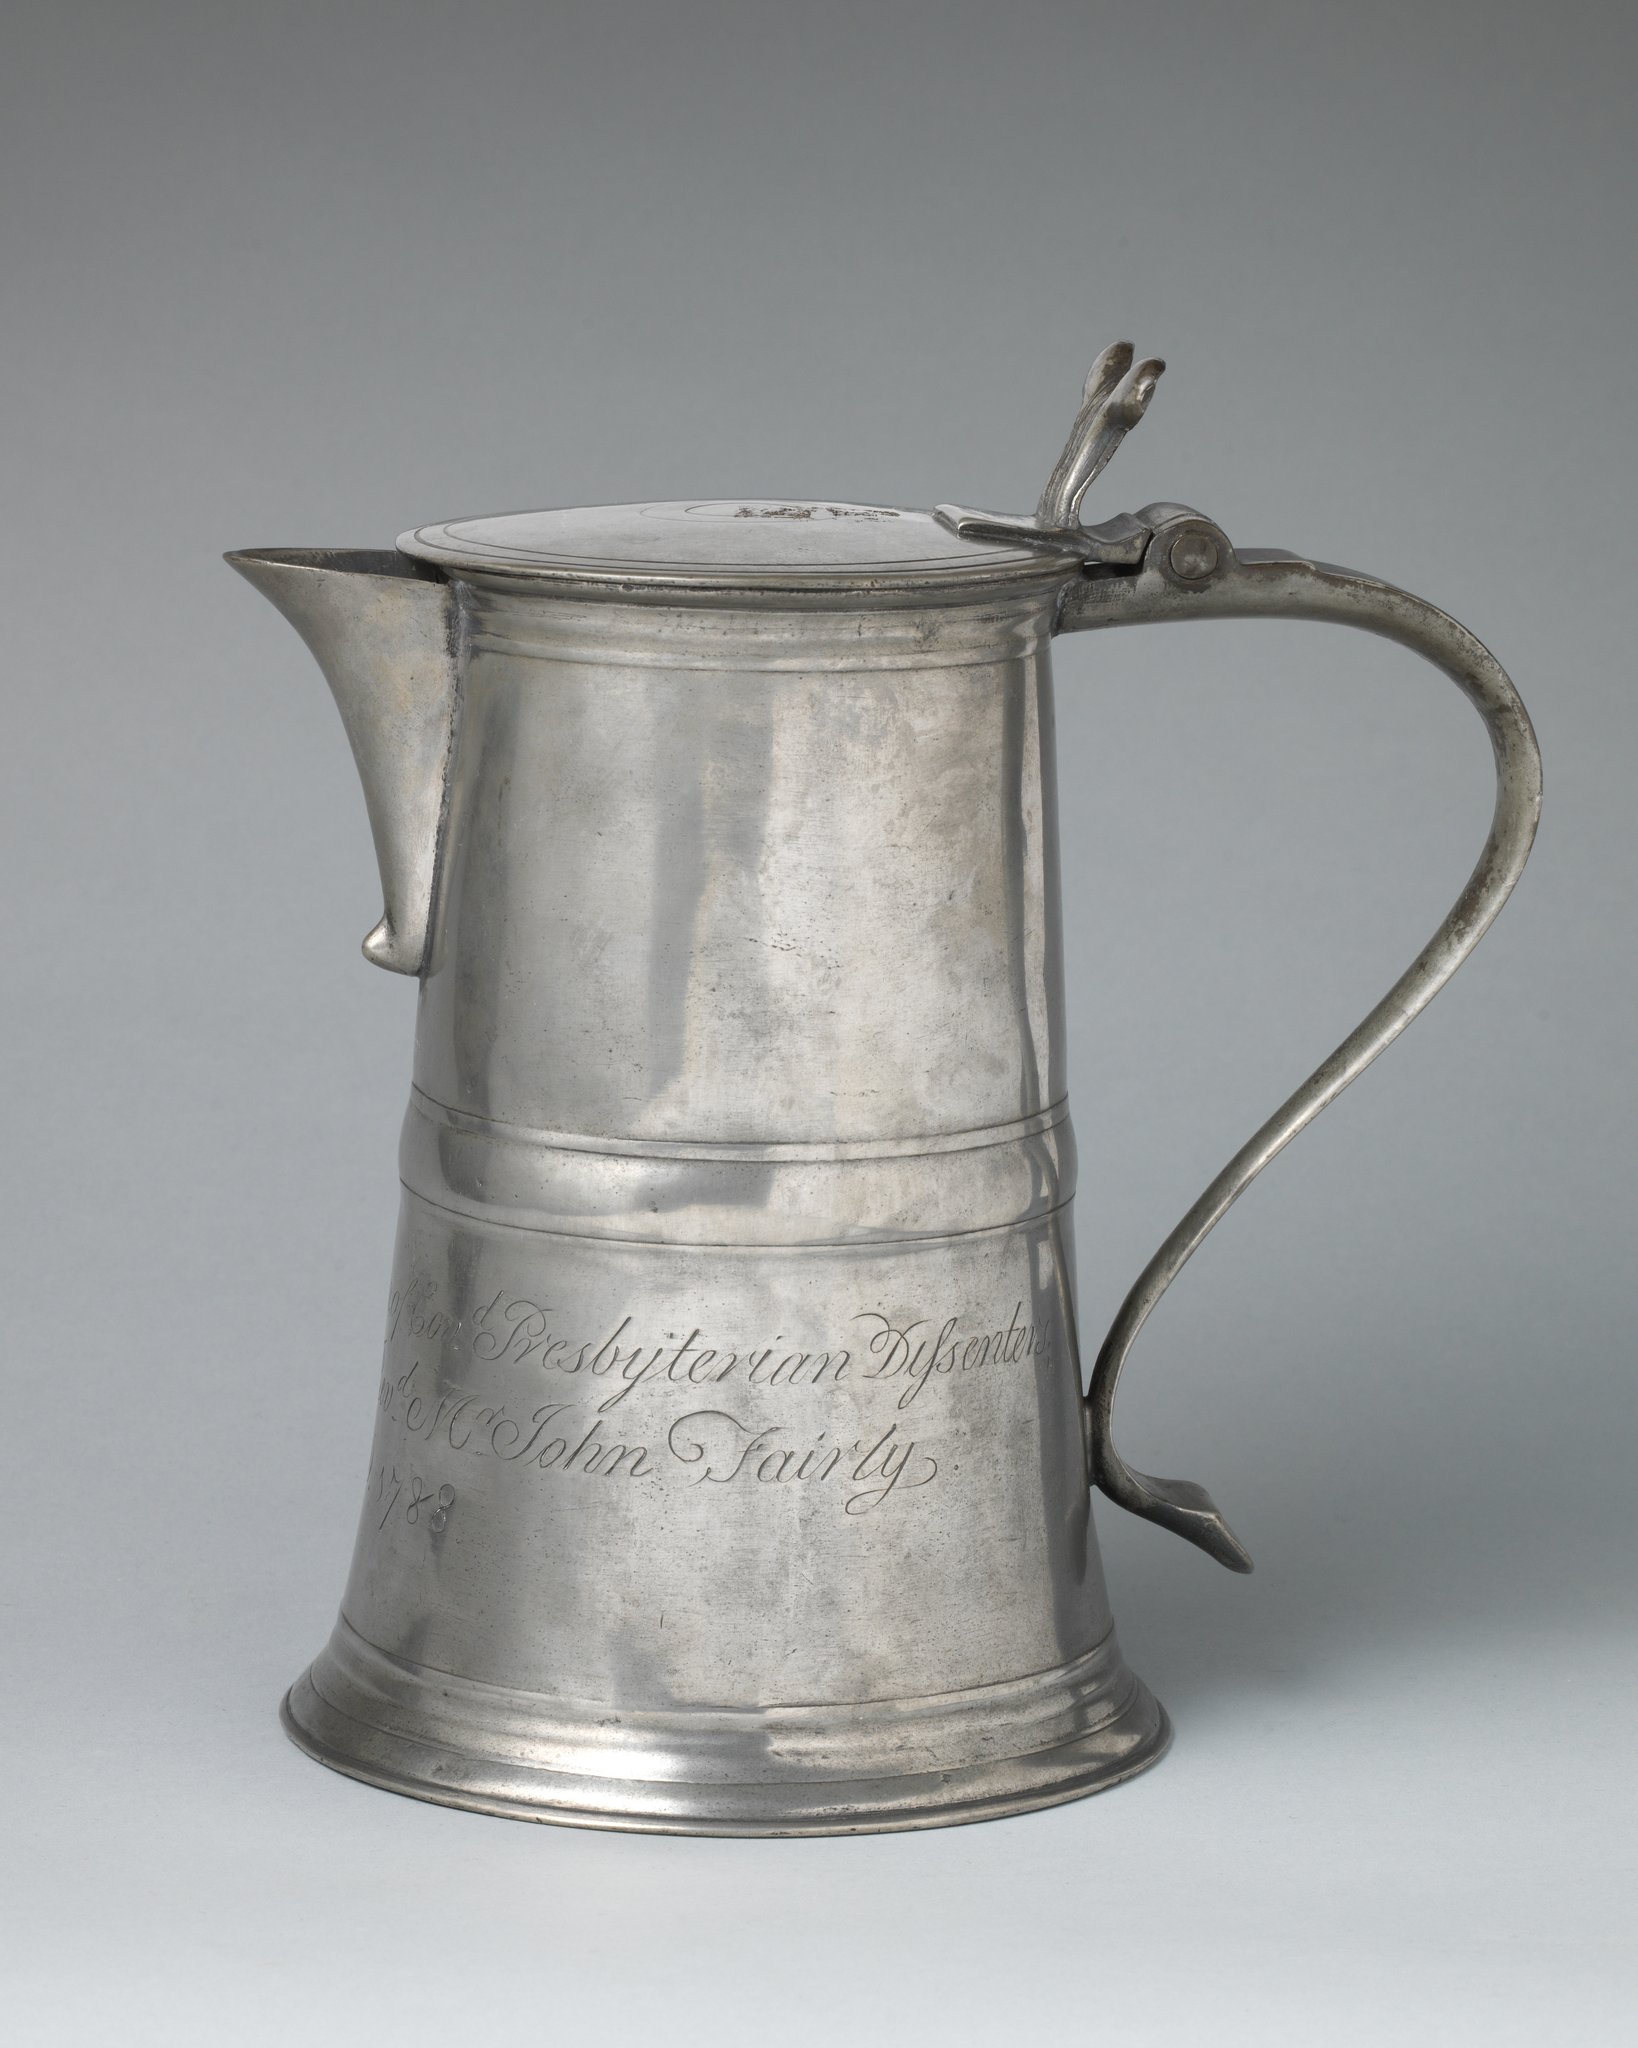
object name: flagon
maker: stephen maxwell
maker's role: maker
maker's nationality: scottish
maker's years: 1781-1784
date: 1788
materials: pewter